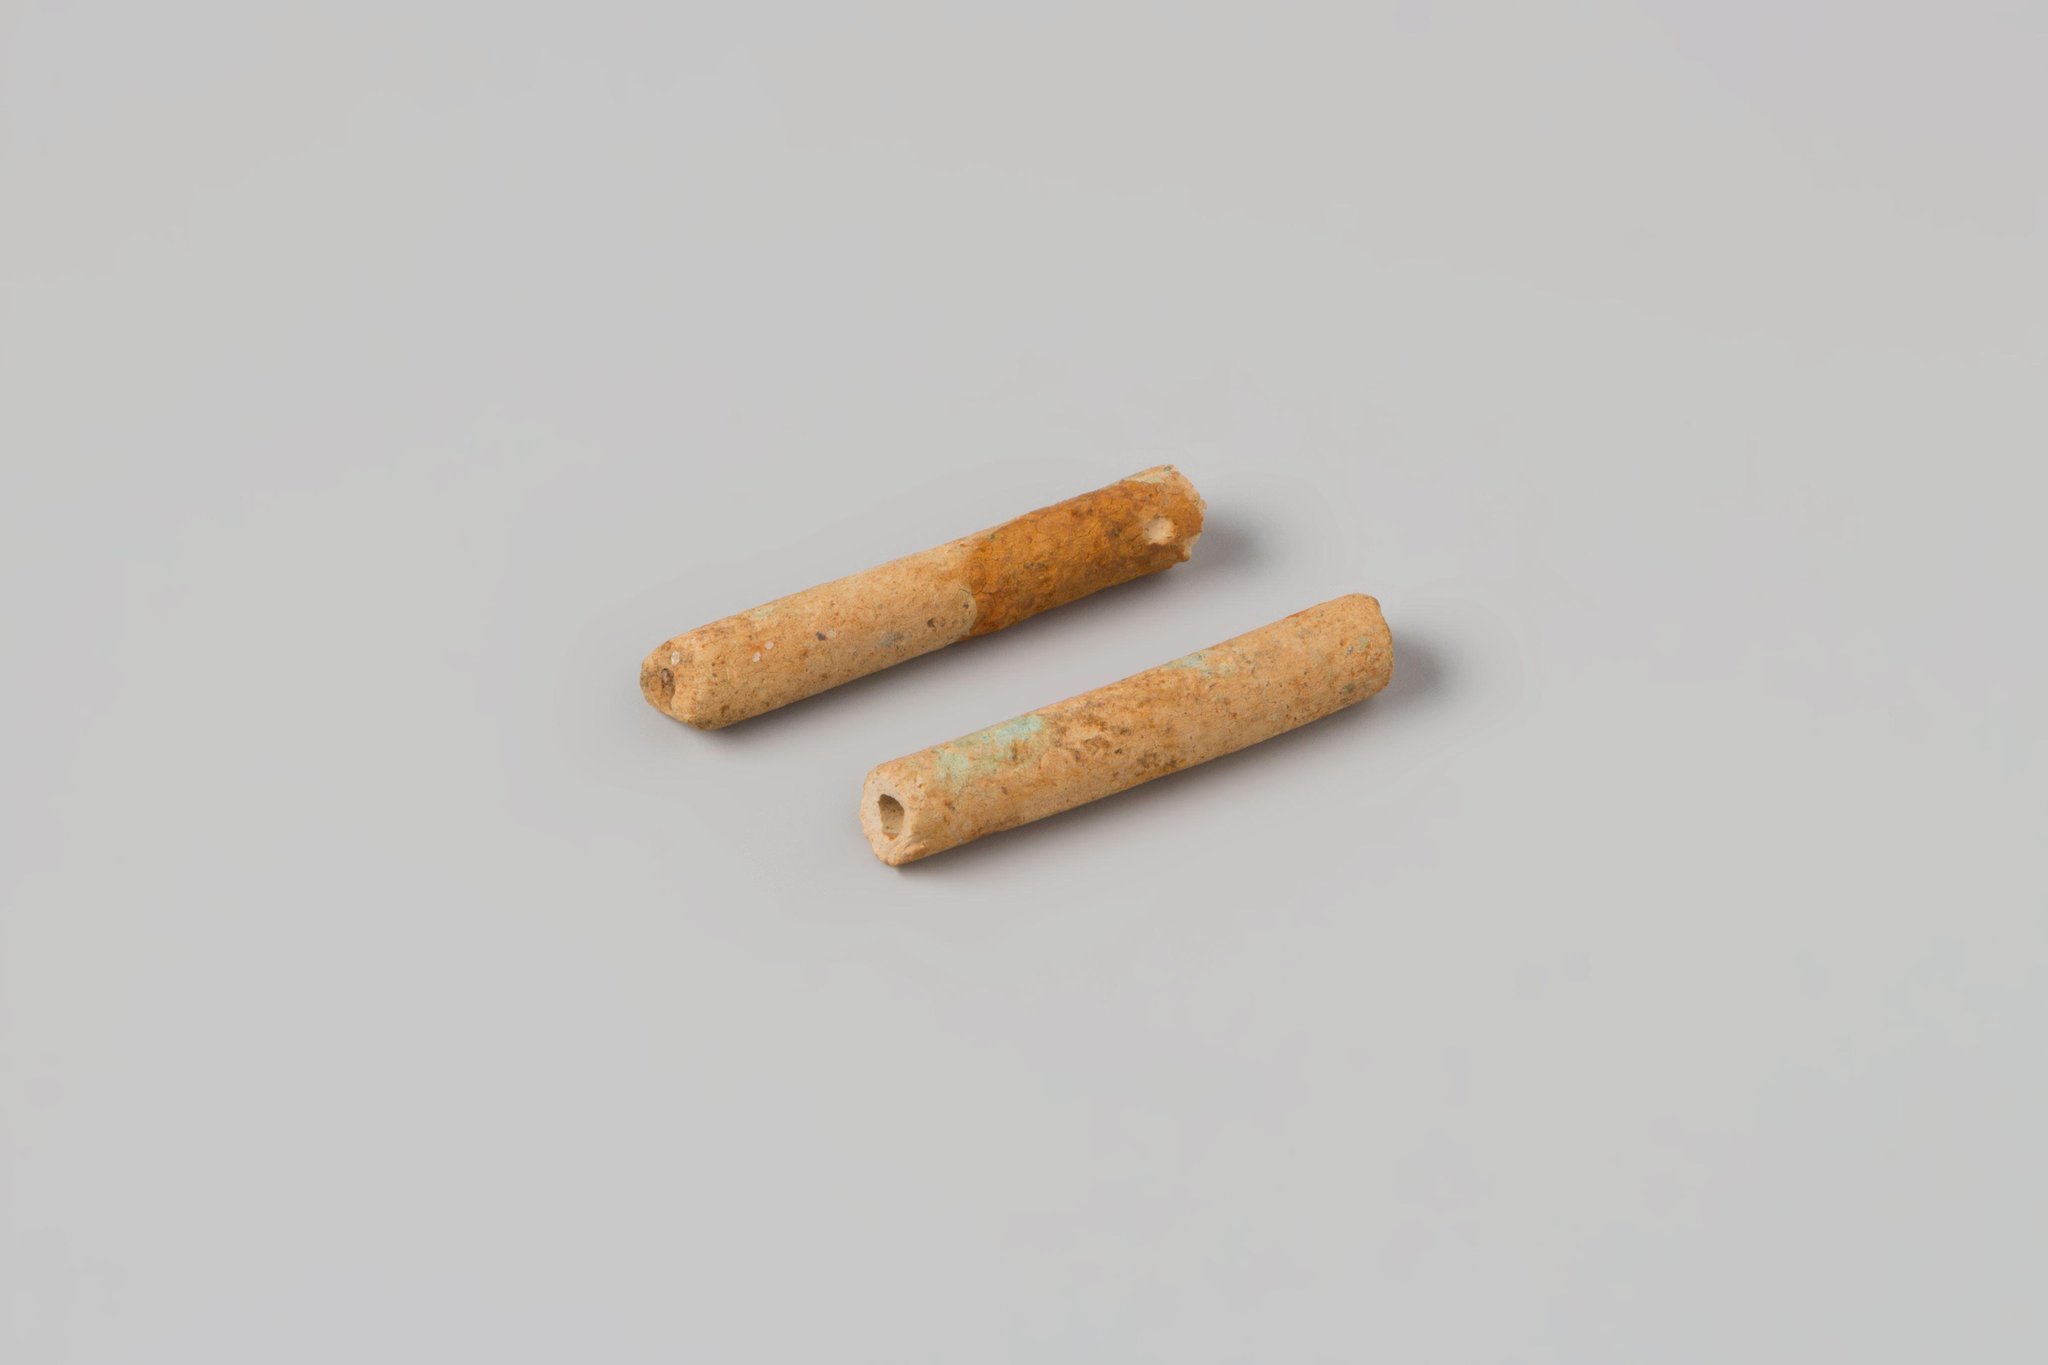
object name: pipe stem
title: Fragmenten pijpensteel uit het wrak van de Oost-Indiëvaarder Hollandia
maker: Anonymous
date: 1700-1743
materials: clay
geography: netherlands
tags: verenigde oostindische compagnie, hollandia (schip), annet